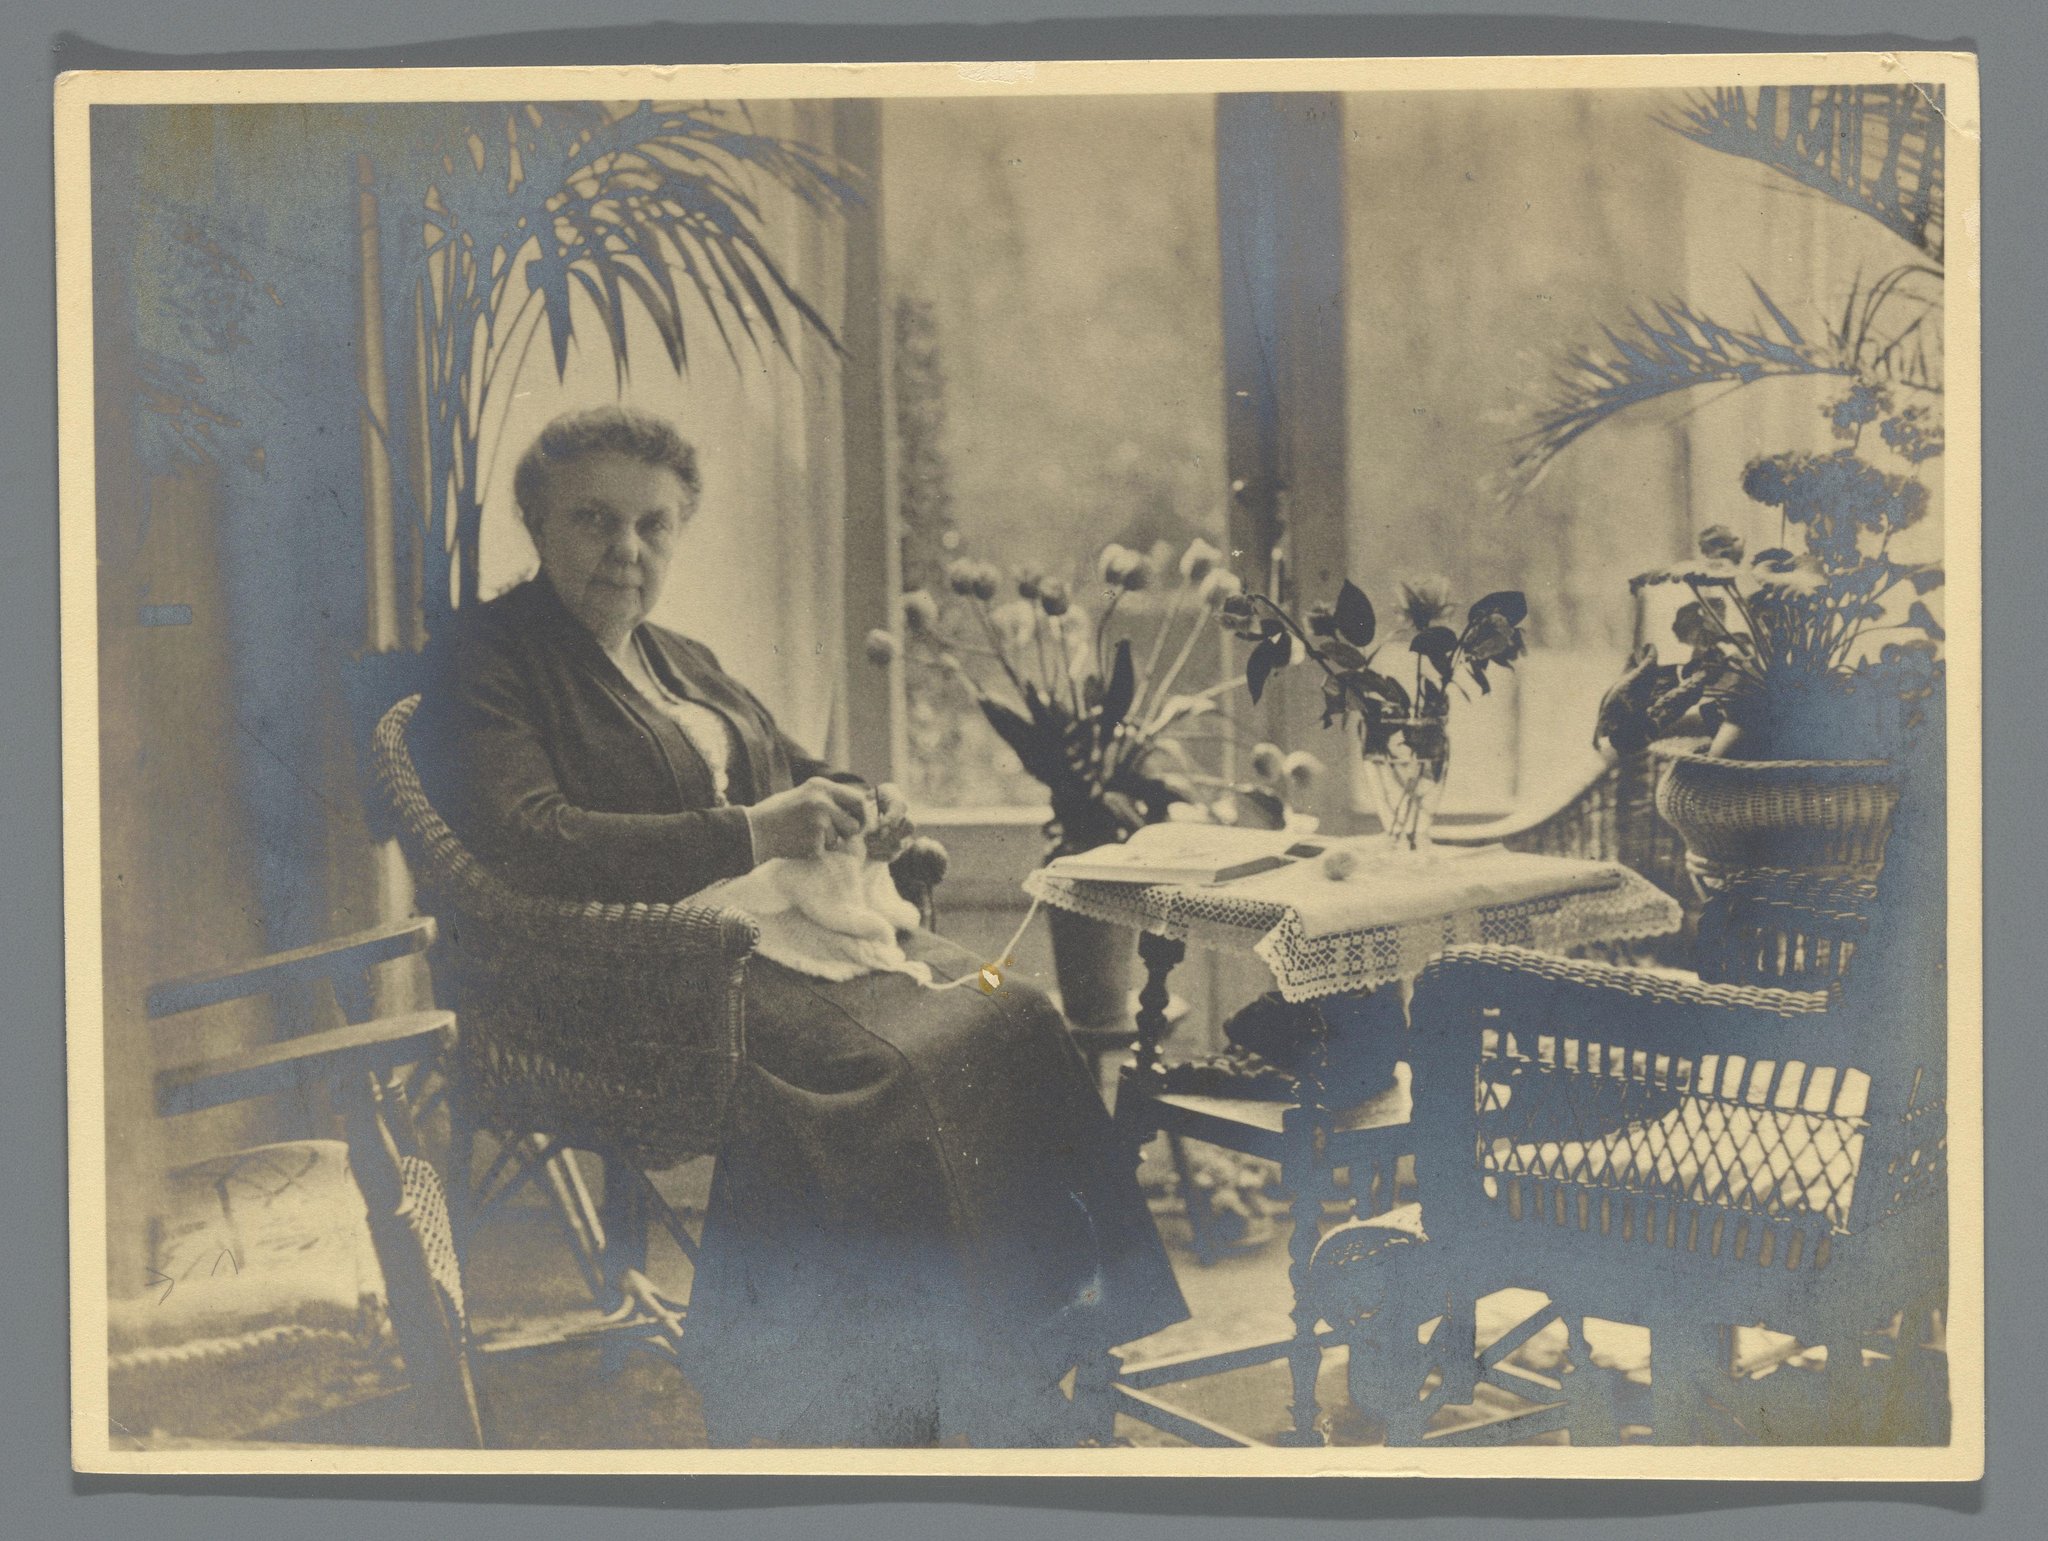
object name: photograph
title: Portret van Henriette Teding van Berkhout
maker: Anonymous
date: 1915-1938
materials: photographic support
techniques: photography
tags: historical persons - bb - woman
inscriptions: annotation: ‘tante Jet de Clercq-T.v.B. / een der kinderen uit het eerste huwelijk (T.v.B.-Fonteyn) van H. T.v.B. Sr. († 1904)’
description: Portret van Jkvr. Henriette de Clercq-Teding van Berkhout, zittend breiend in een stoel.